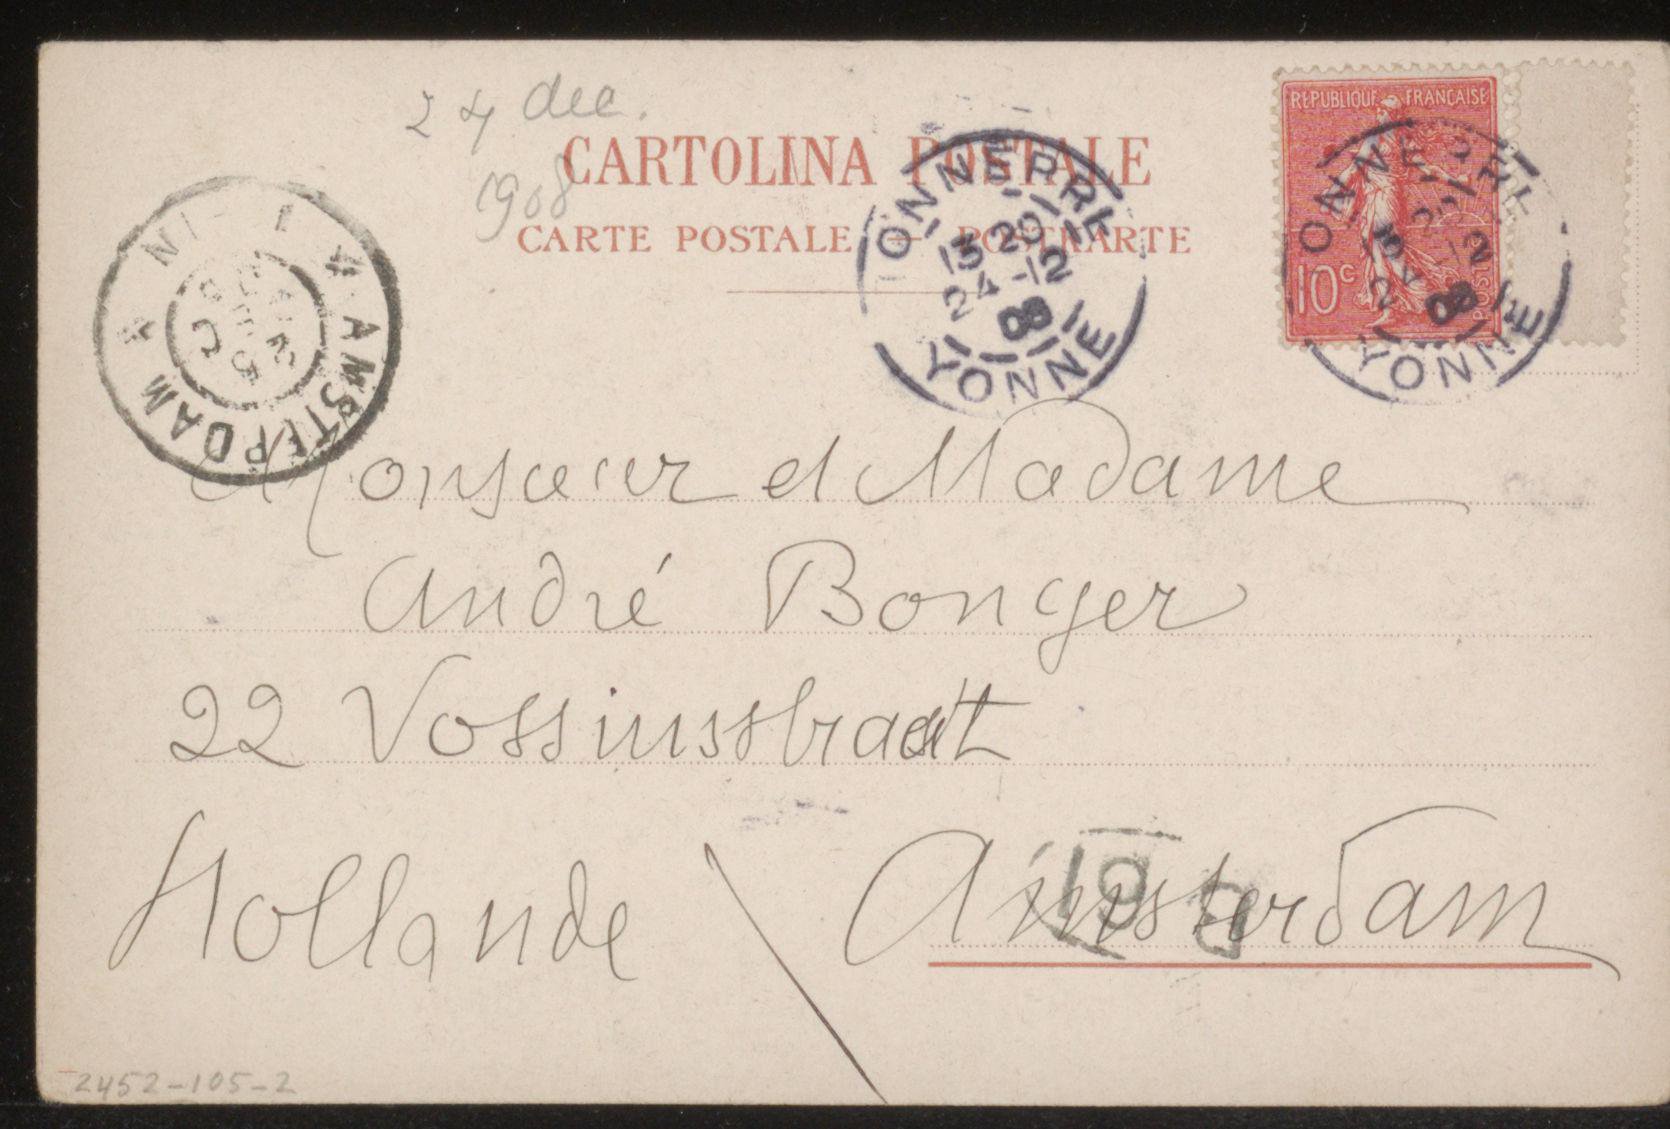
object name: ansichtkaart, prentbriefkaart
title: Prentbriefkaart aan Andries Bonger en Anne Marie Louise van der Linden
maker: émile bernard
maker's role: print maker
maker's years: 1868-1941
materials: cardboard, ink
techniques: pen, photoaquatint, writing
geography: naples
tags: painter, print maker, draughtsman, vincent van gogh, amsterdam, andries bonger